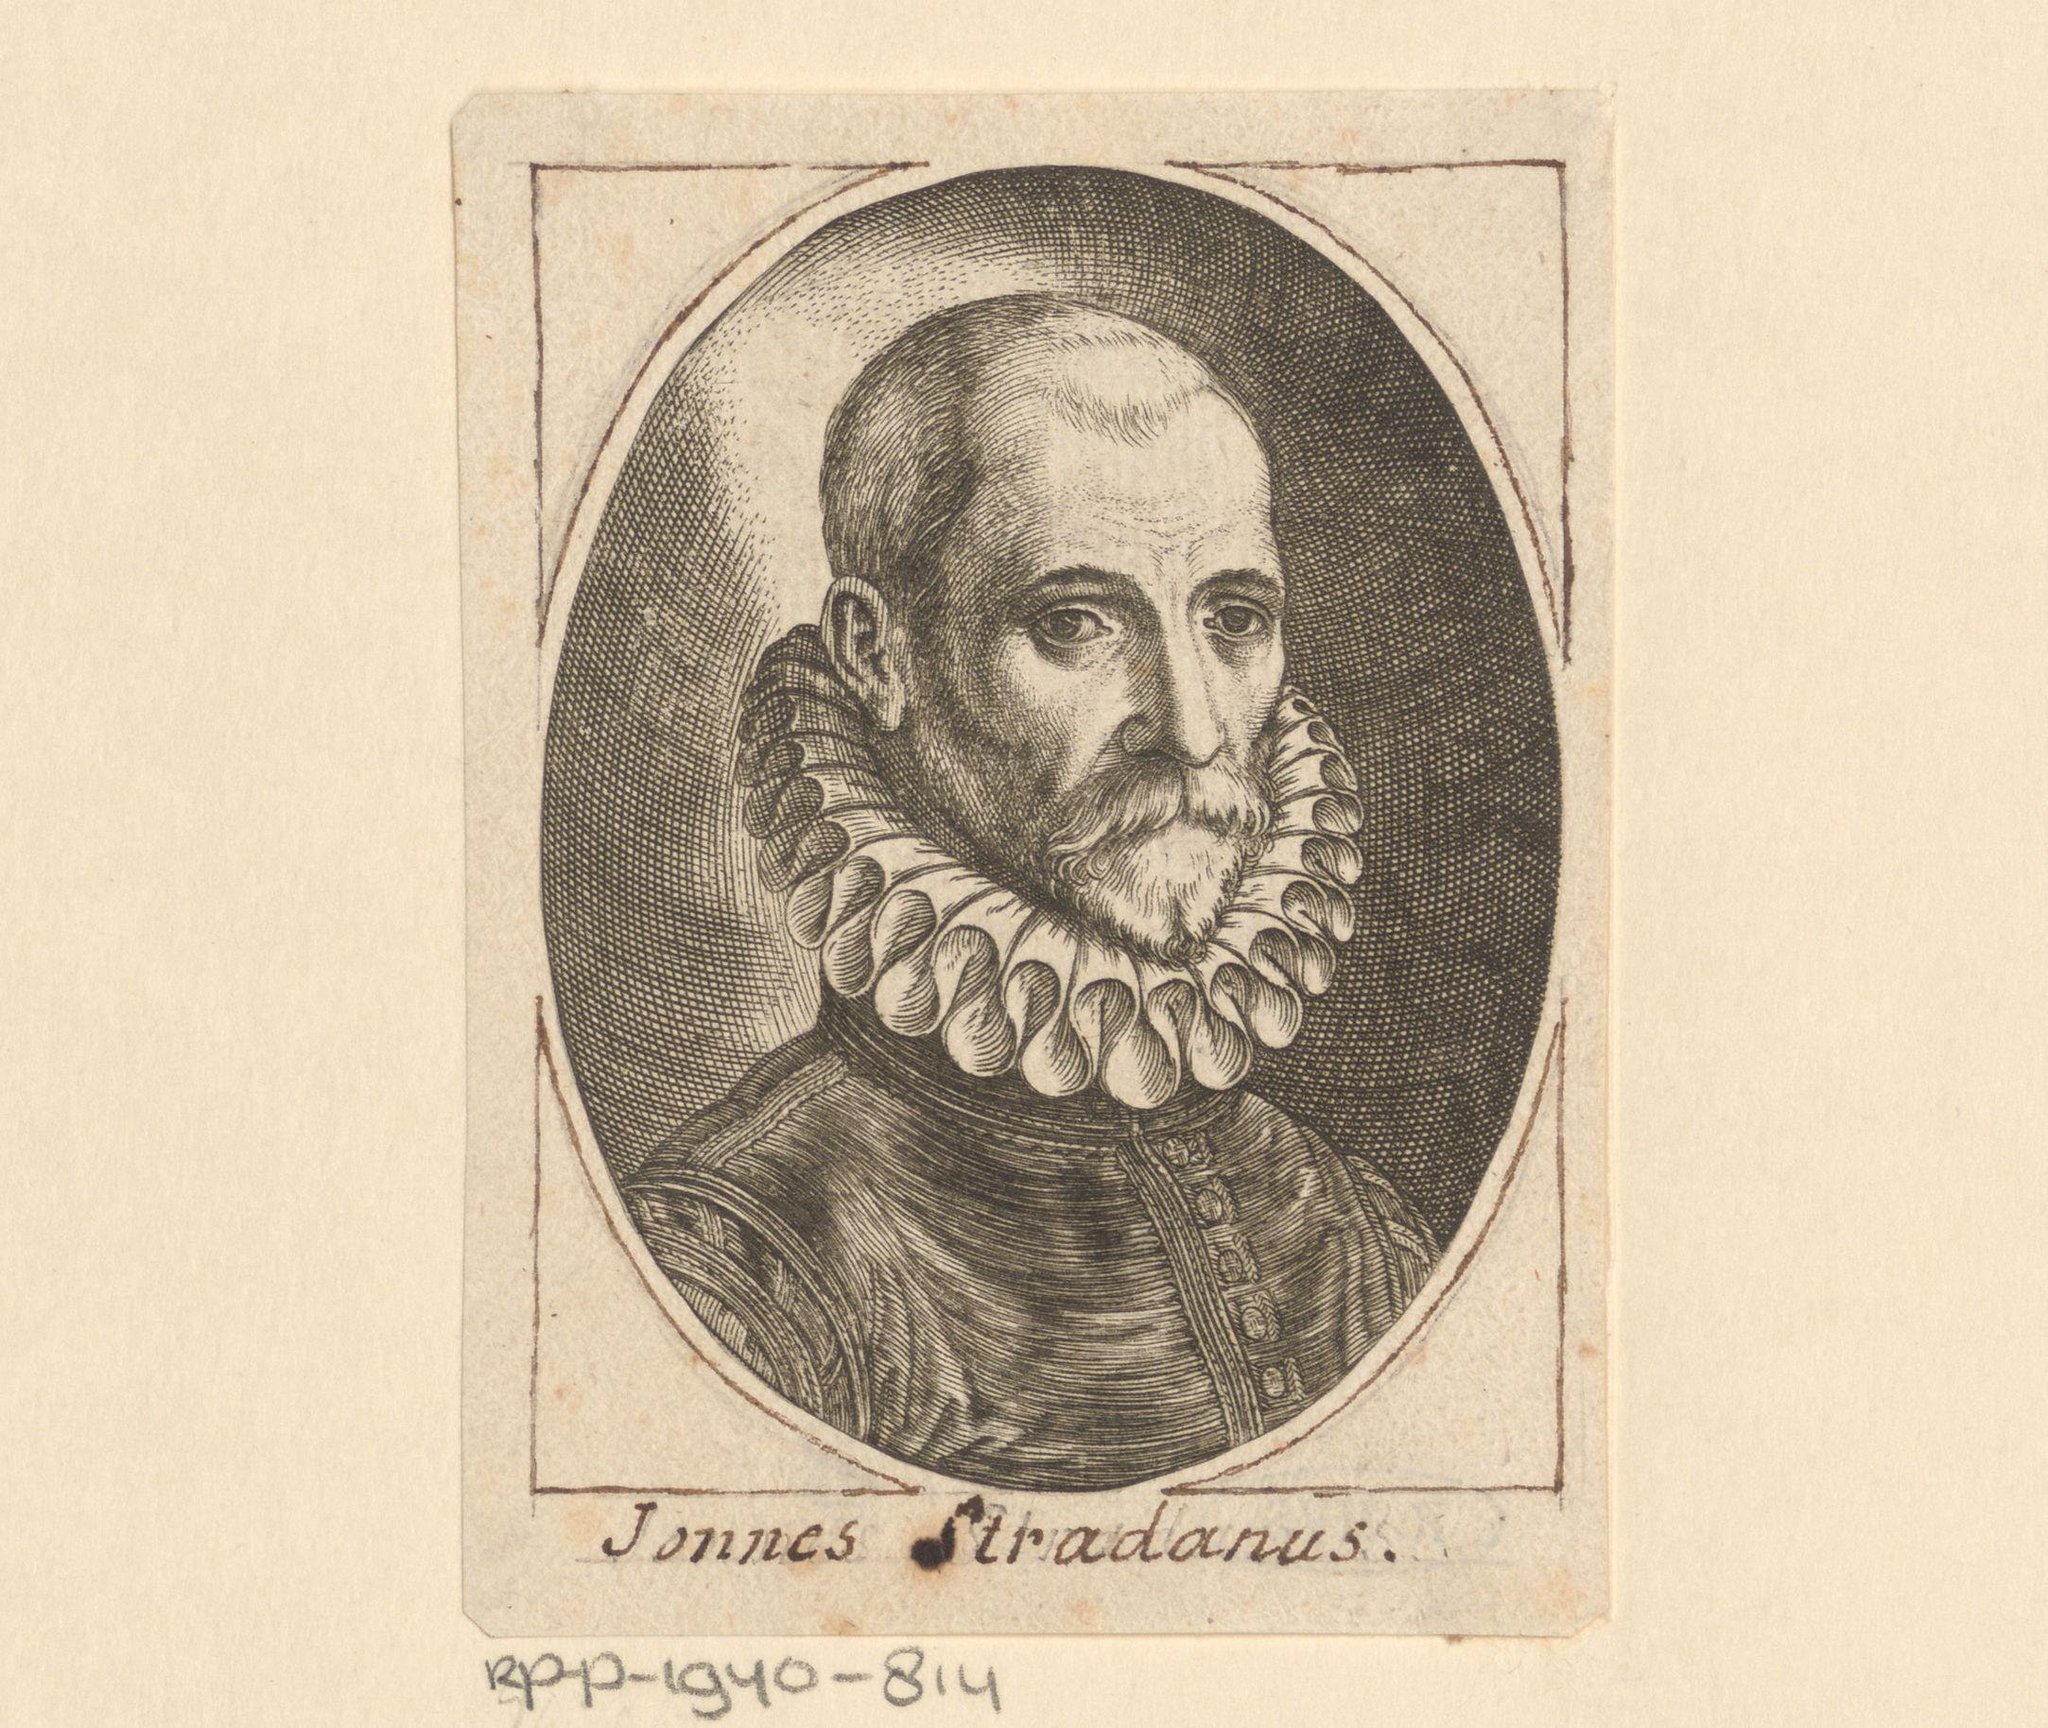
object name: print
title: Portret van Jan van der Straet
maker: Anonymous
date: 1580-1650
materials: ink, paper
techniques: engraving, pen, snipping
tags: bruges, draughtsman, jan van der straet, historical persons, portrait, self-portrait of artist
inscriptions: collector's mark: Lugt 2228, collector's mark: Lugt 2760, name: ‘Jonnes Stradanus’